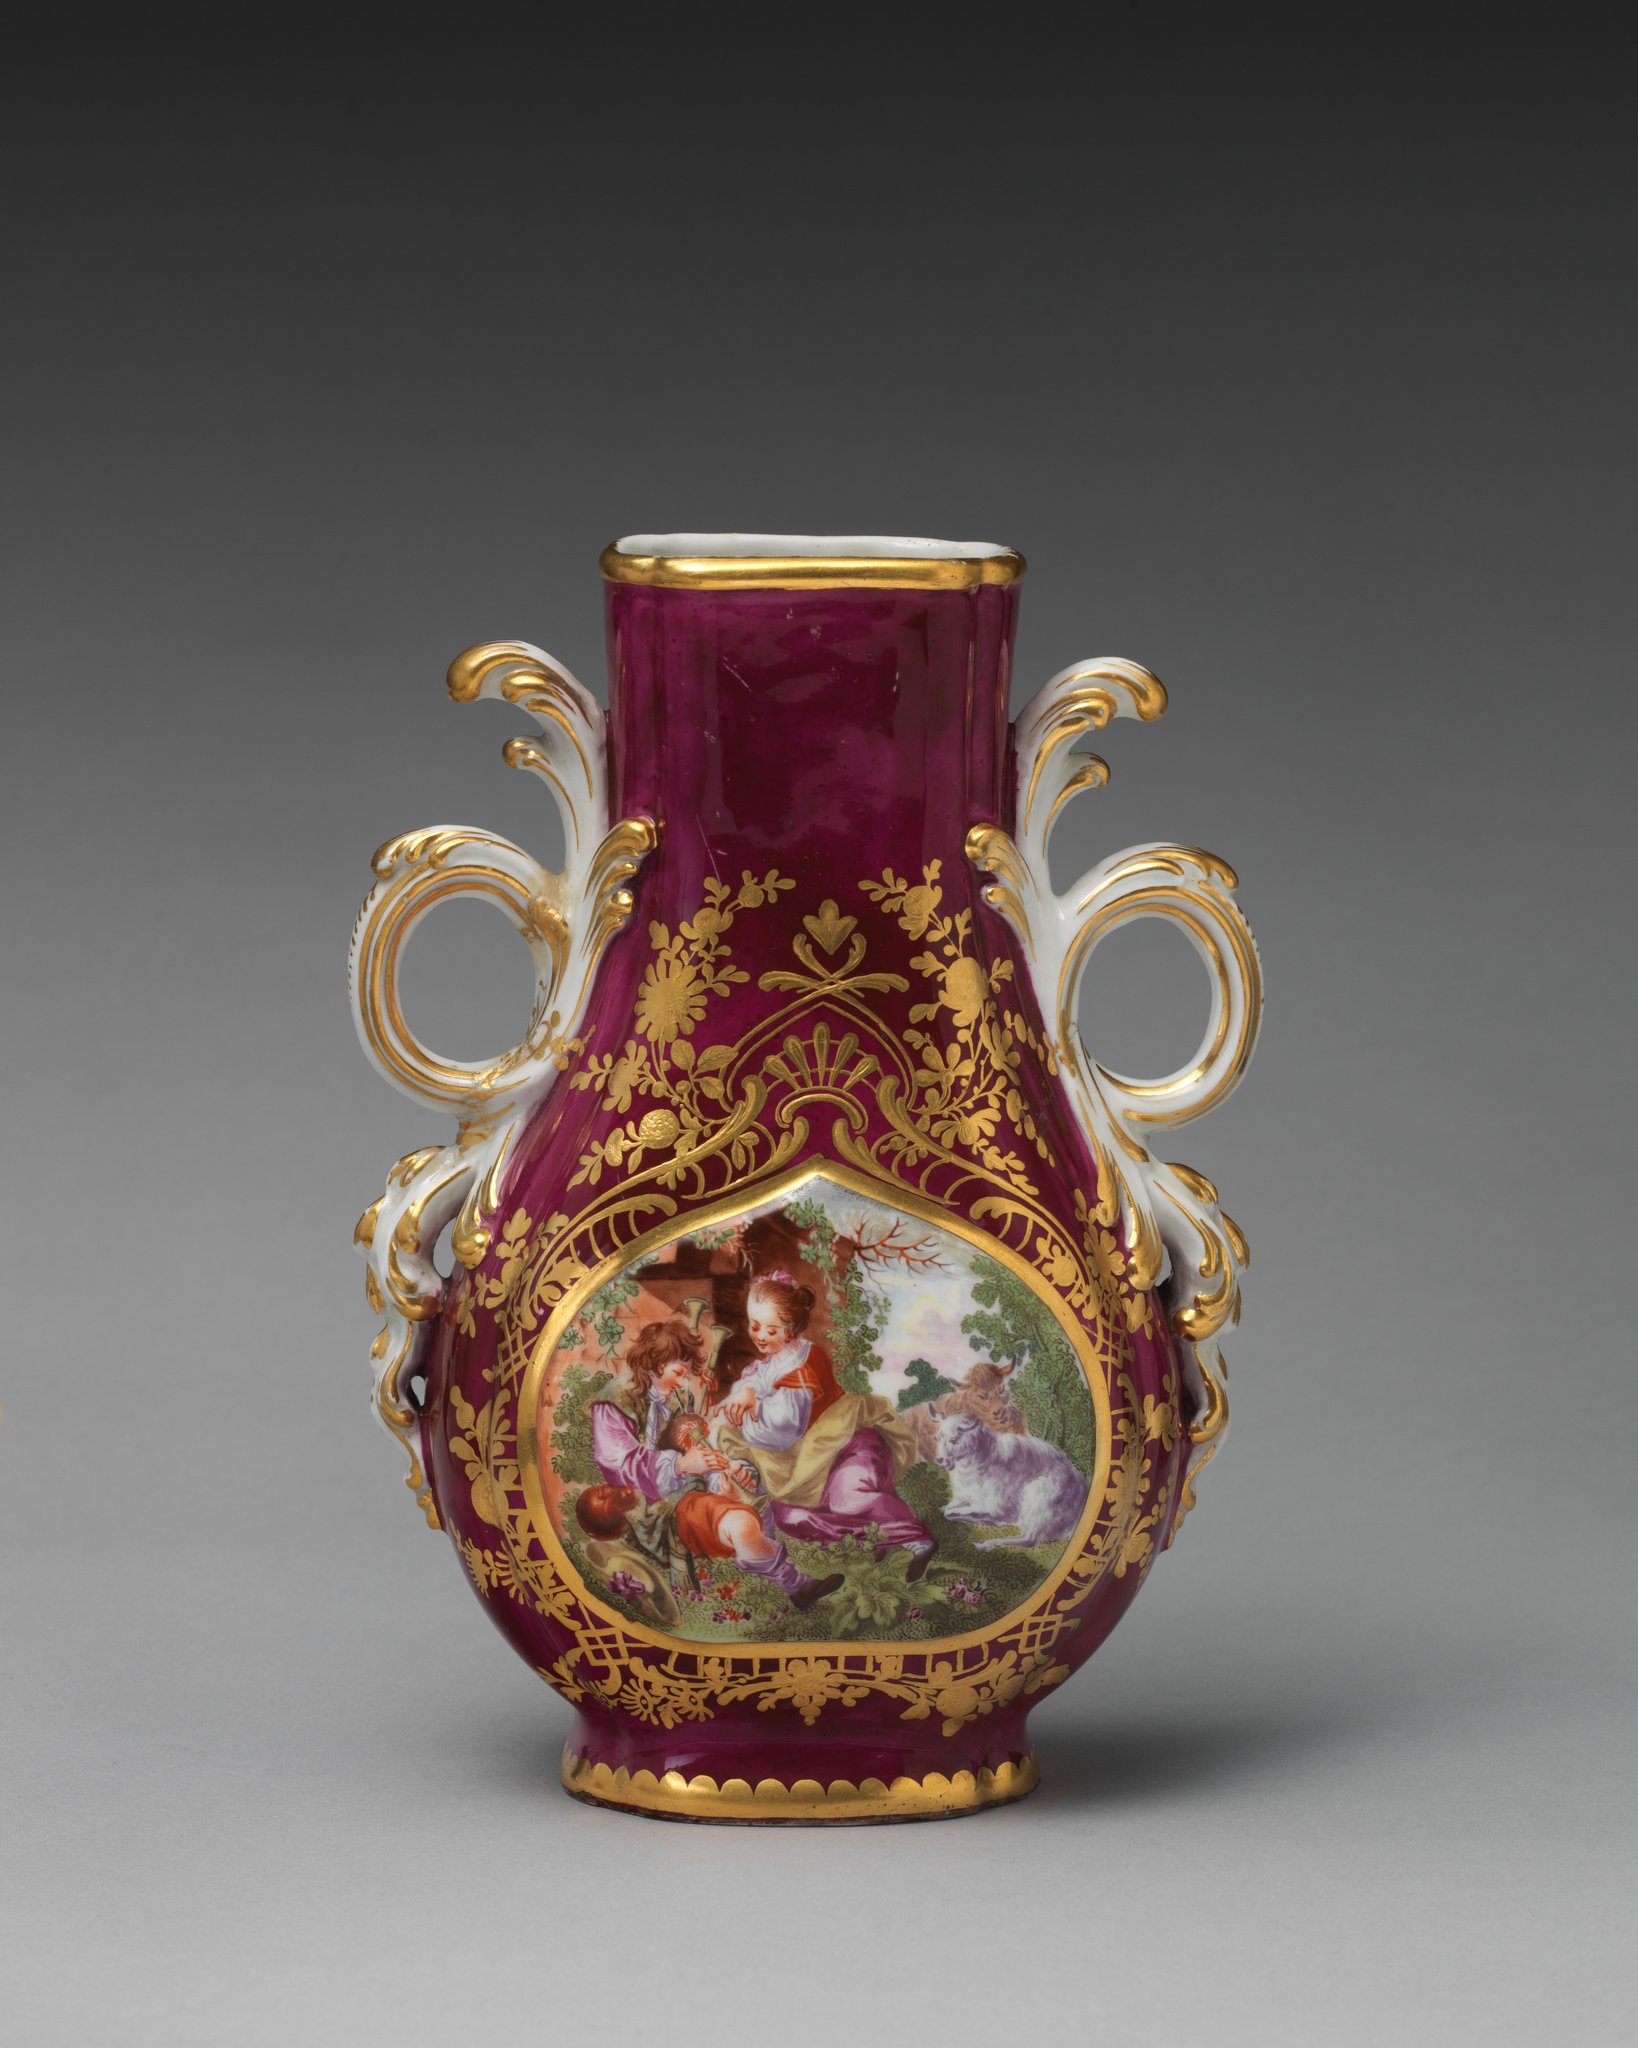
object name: vase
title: Vase (one of a pair)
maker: chelsea porcelain manufactory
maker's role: factory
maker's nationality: british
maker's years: 1744-1784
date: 1761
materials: soft paste porcelain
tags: boys,girls